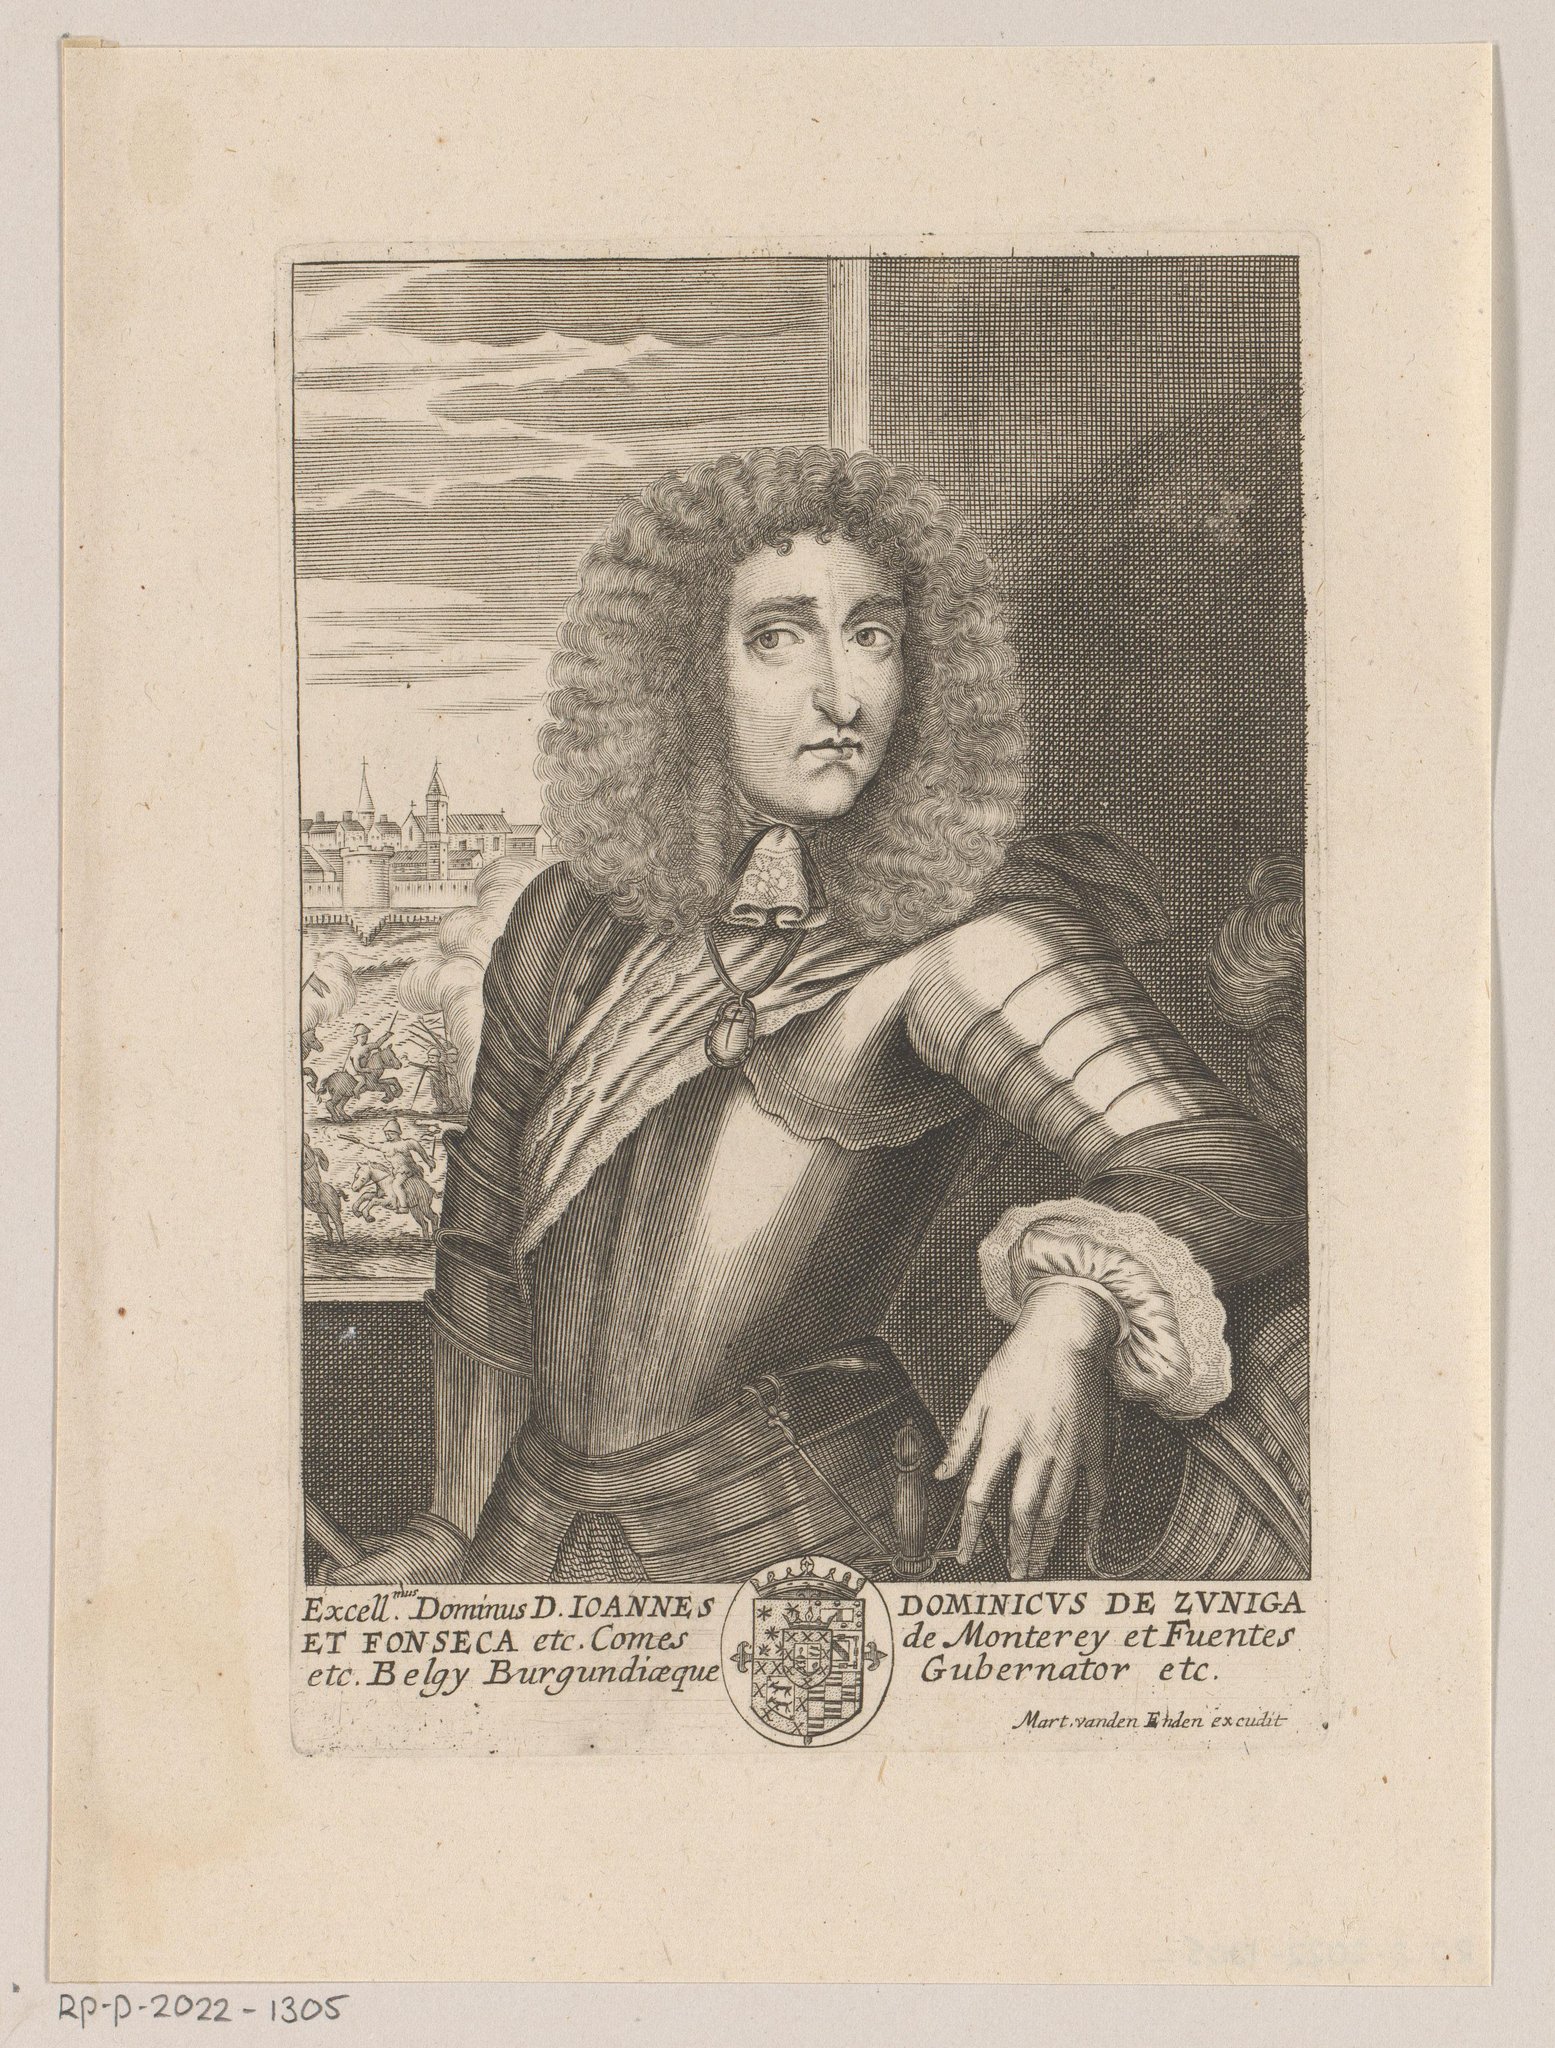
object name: print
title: Portret van Juan Domingo Méndez de Haro y Fernández de Córdoba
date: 1664-1667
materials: paper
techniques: engraving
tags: juan domingo méndez de haro y fernández de córdoba, armour, historical persons